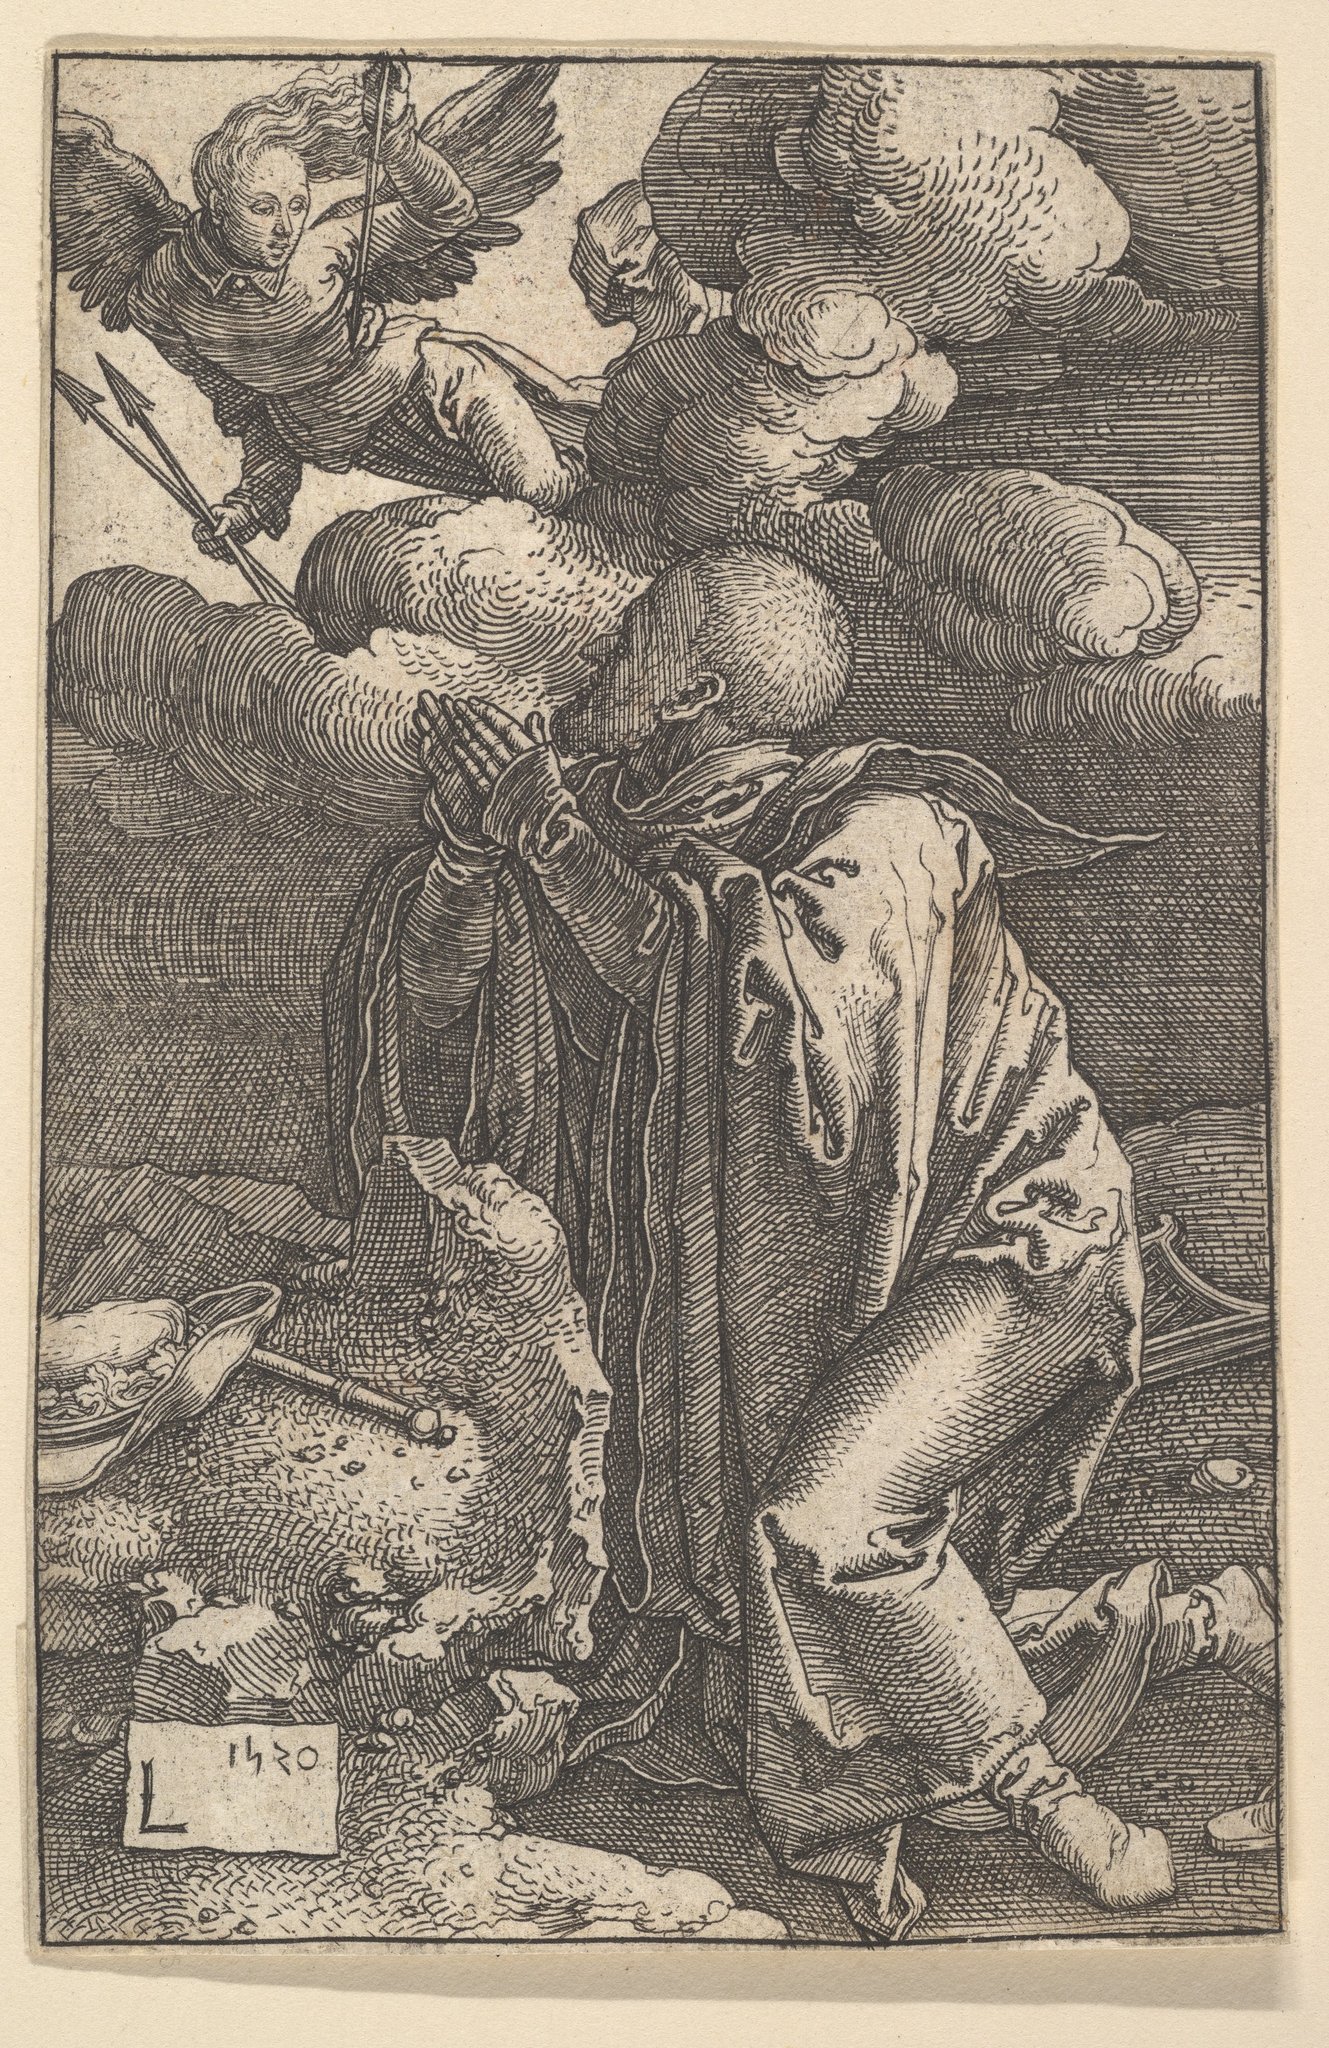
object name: print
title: David Praying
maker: lucas van leyden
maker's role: artist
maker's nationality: netherlandish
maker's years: 1494-1533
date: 1520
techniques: engraving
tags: angels,david,praying